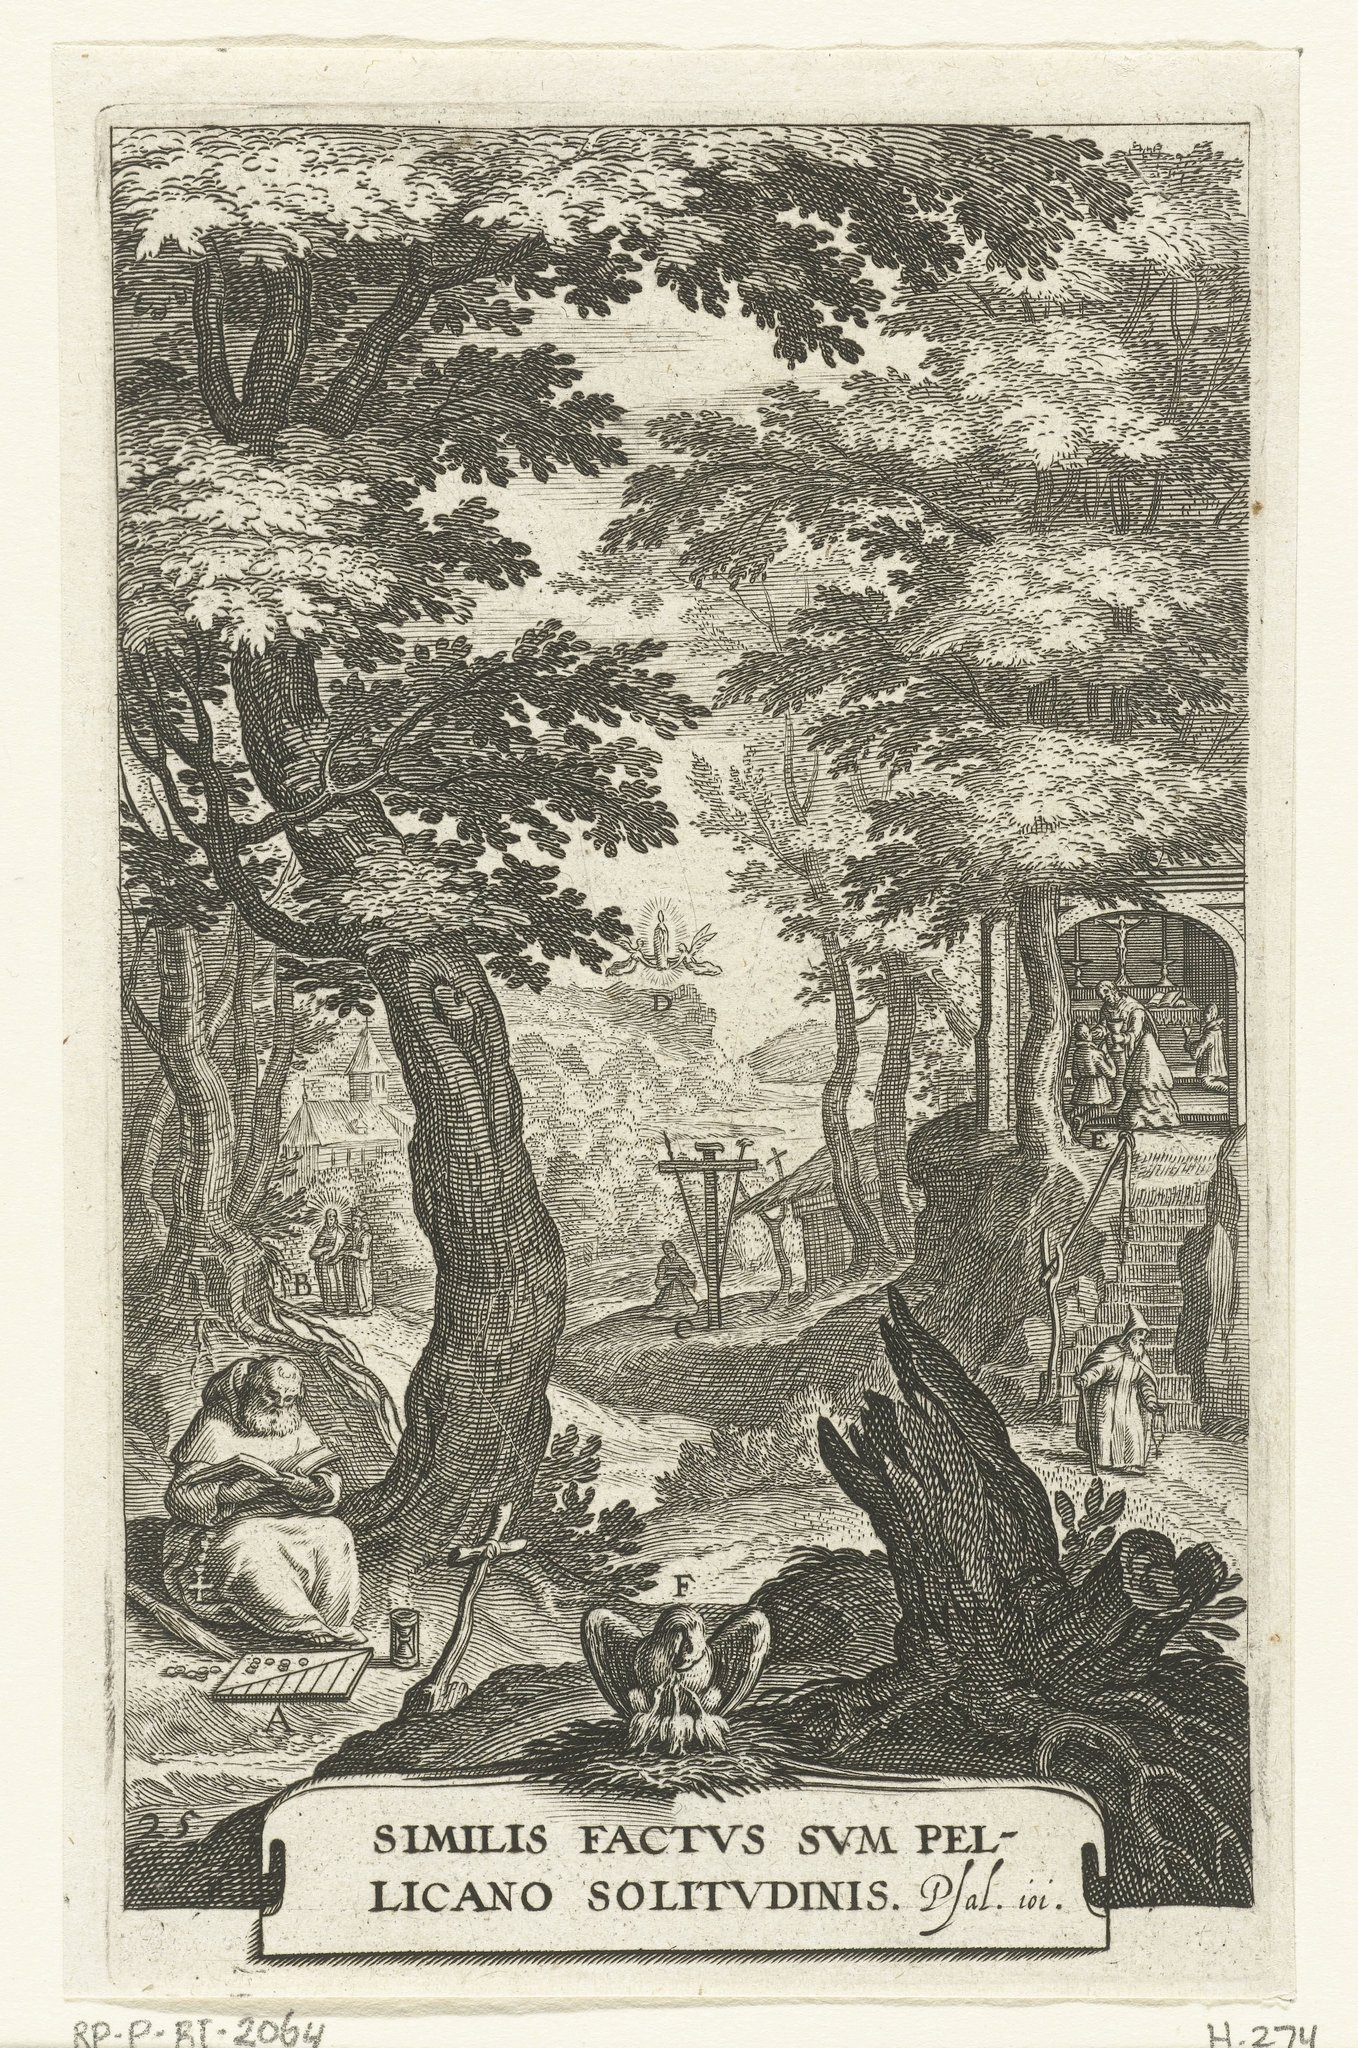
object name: print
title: Den wech des eeuwich levens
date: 1620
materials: paper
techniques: engraving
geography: antwerp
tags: symbols of christ ~ animals, anchorite, hermit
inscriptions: collector's mark: Lugt 2228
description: Landschap met een kluizenaar die zich in afzondering verdiept in de bijbel. Kleine scènes illustreren waarin een goede christen moet geloven. In een interieur van een kapel knielen gelovigen en ontvangen een hostie, het heilige sacrament van een priester. Een gelovige mediteert bij een kruis met lijdenswerktuigen van Christus. Nauwelijks zichtbaar tussen het gebladerte van de bomen is de hemelvaart van Christus weergegeven. Het opschrift verwijst naar de bijbeltekst Ik ben als een pelikaan in de woestijn (Psalmen 102) en deze is geillustreerd met het symbool voor de lijdende Christus, de pelikaan die haar jongen voedt met haar eigen bloed. Bij de scènes staan letters die verband houden met het meditatievoorschrift in de uitgave.